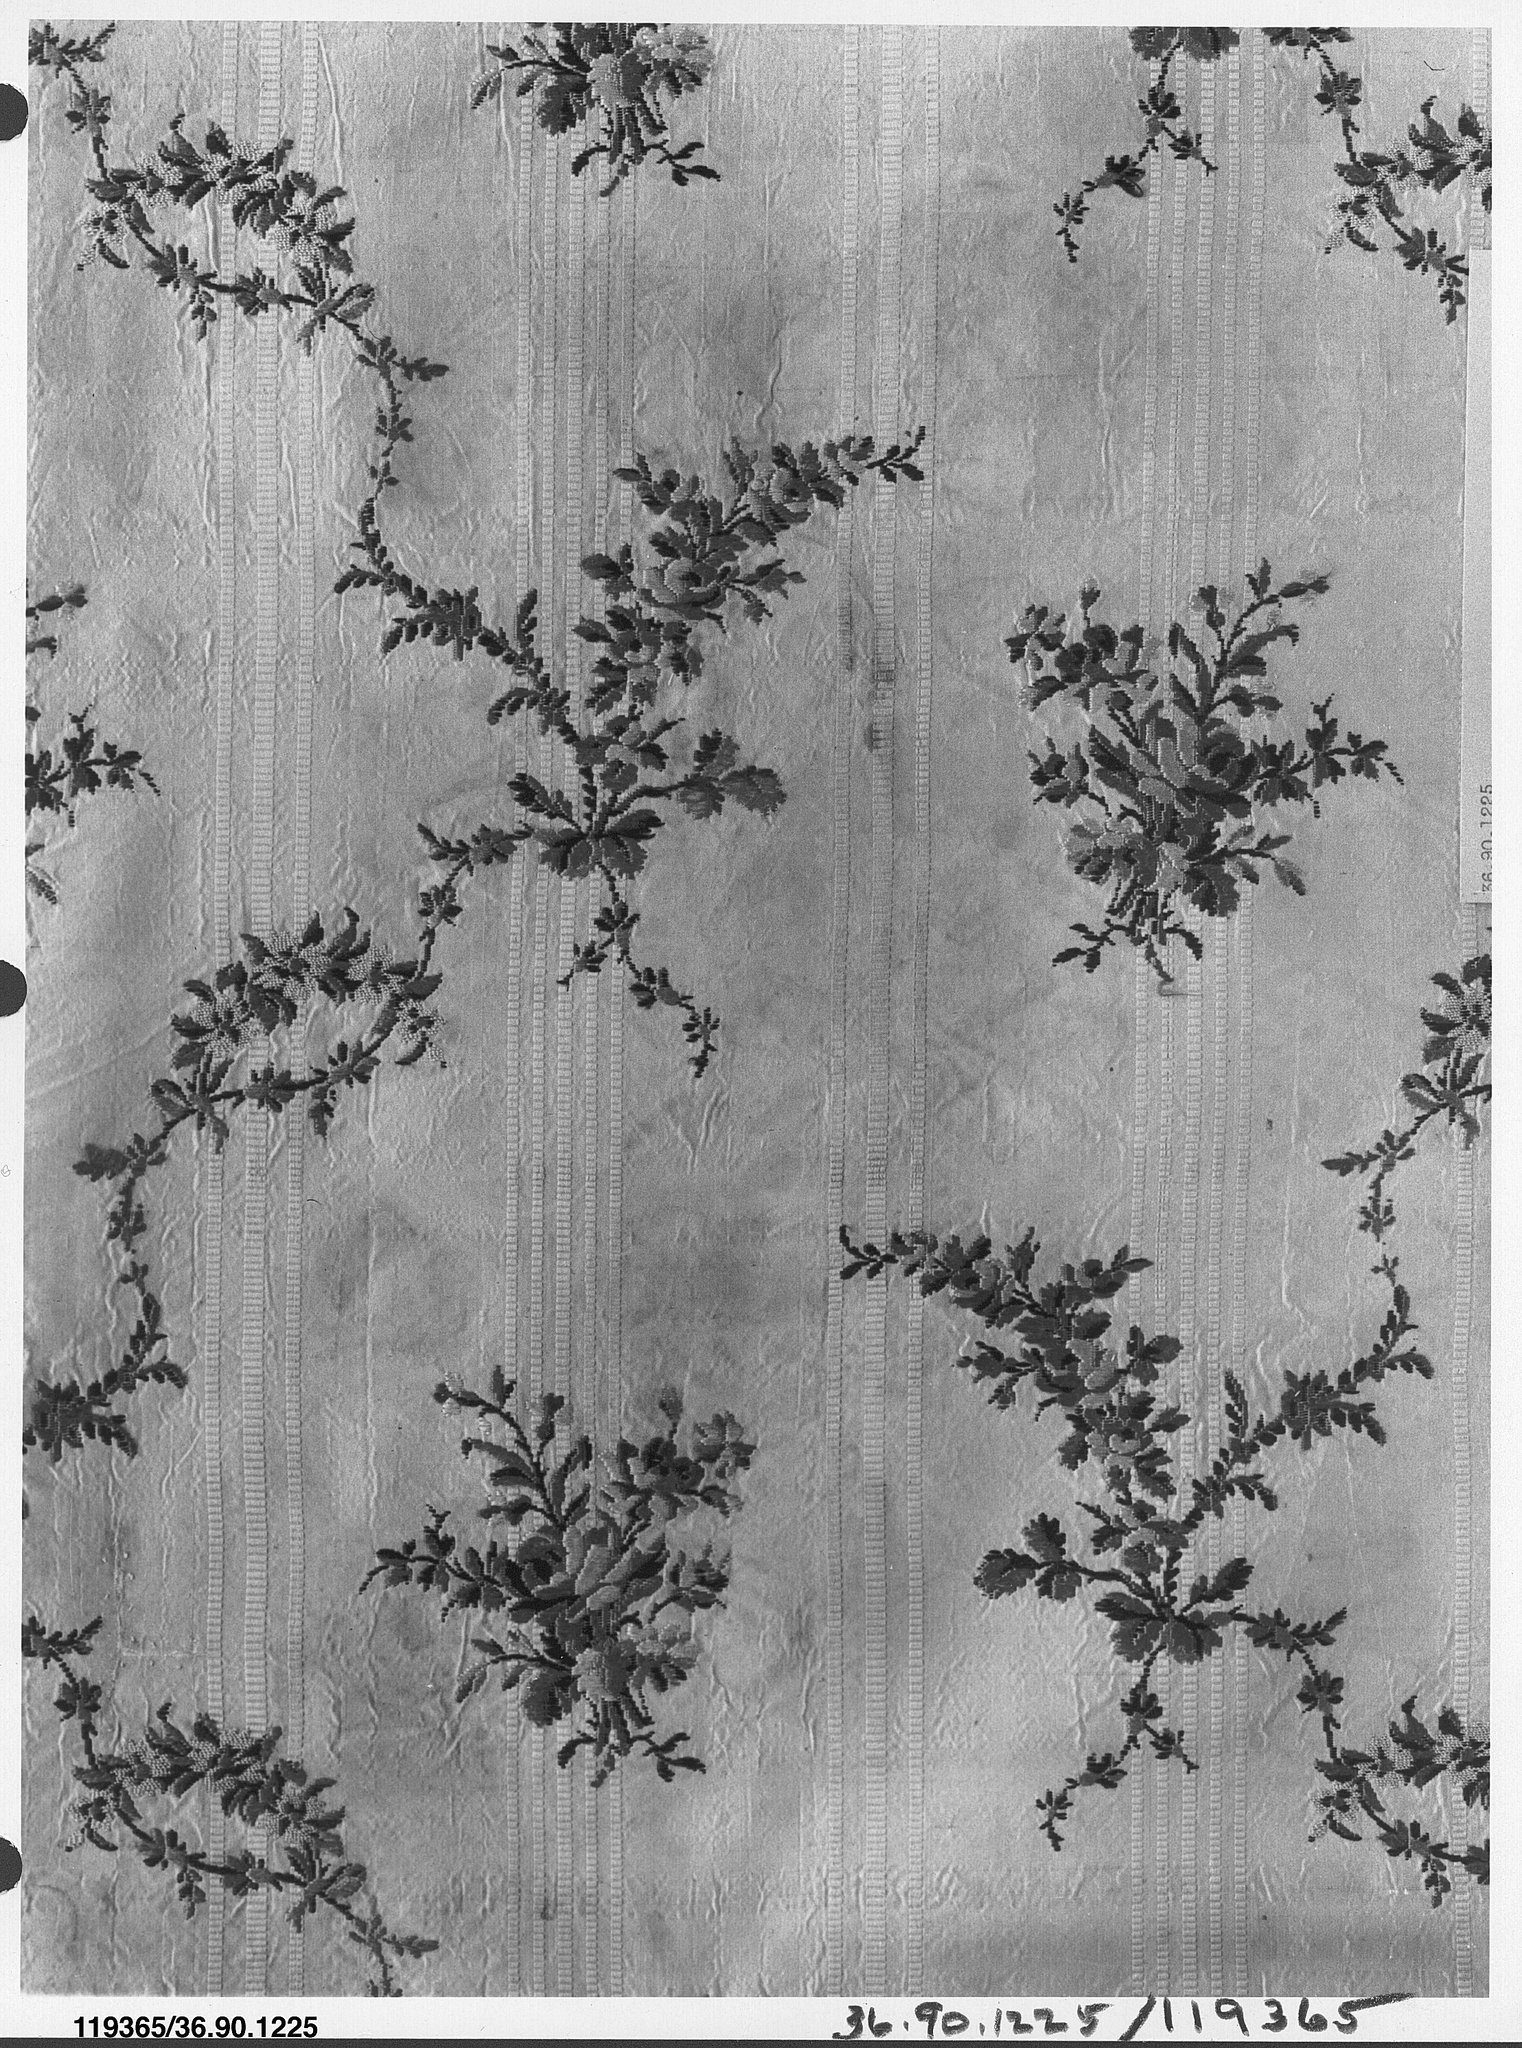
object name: piece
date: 1701-1800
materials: silk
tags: flowers,leaves